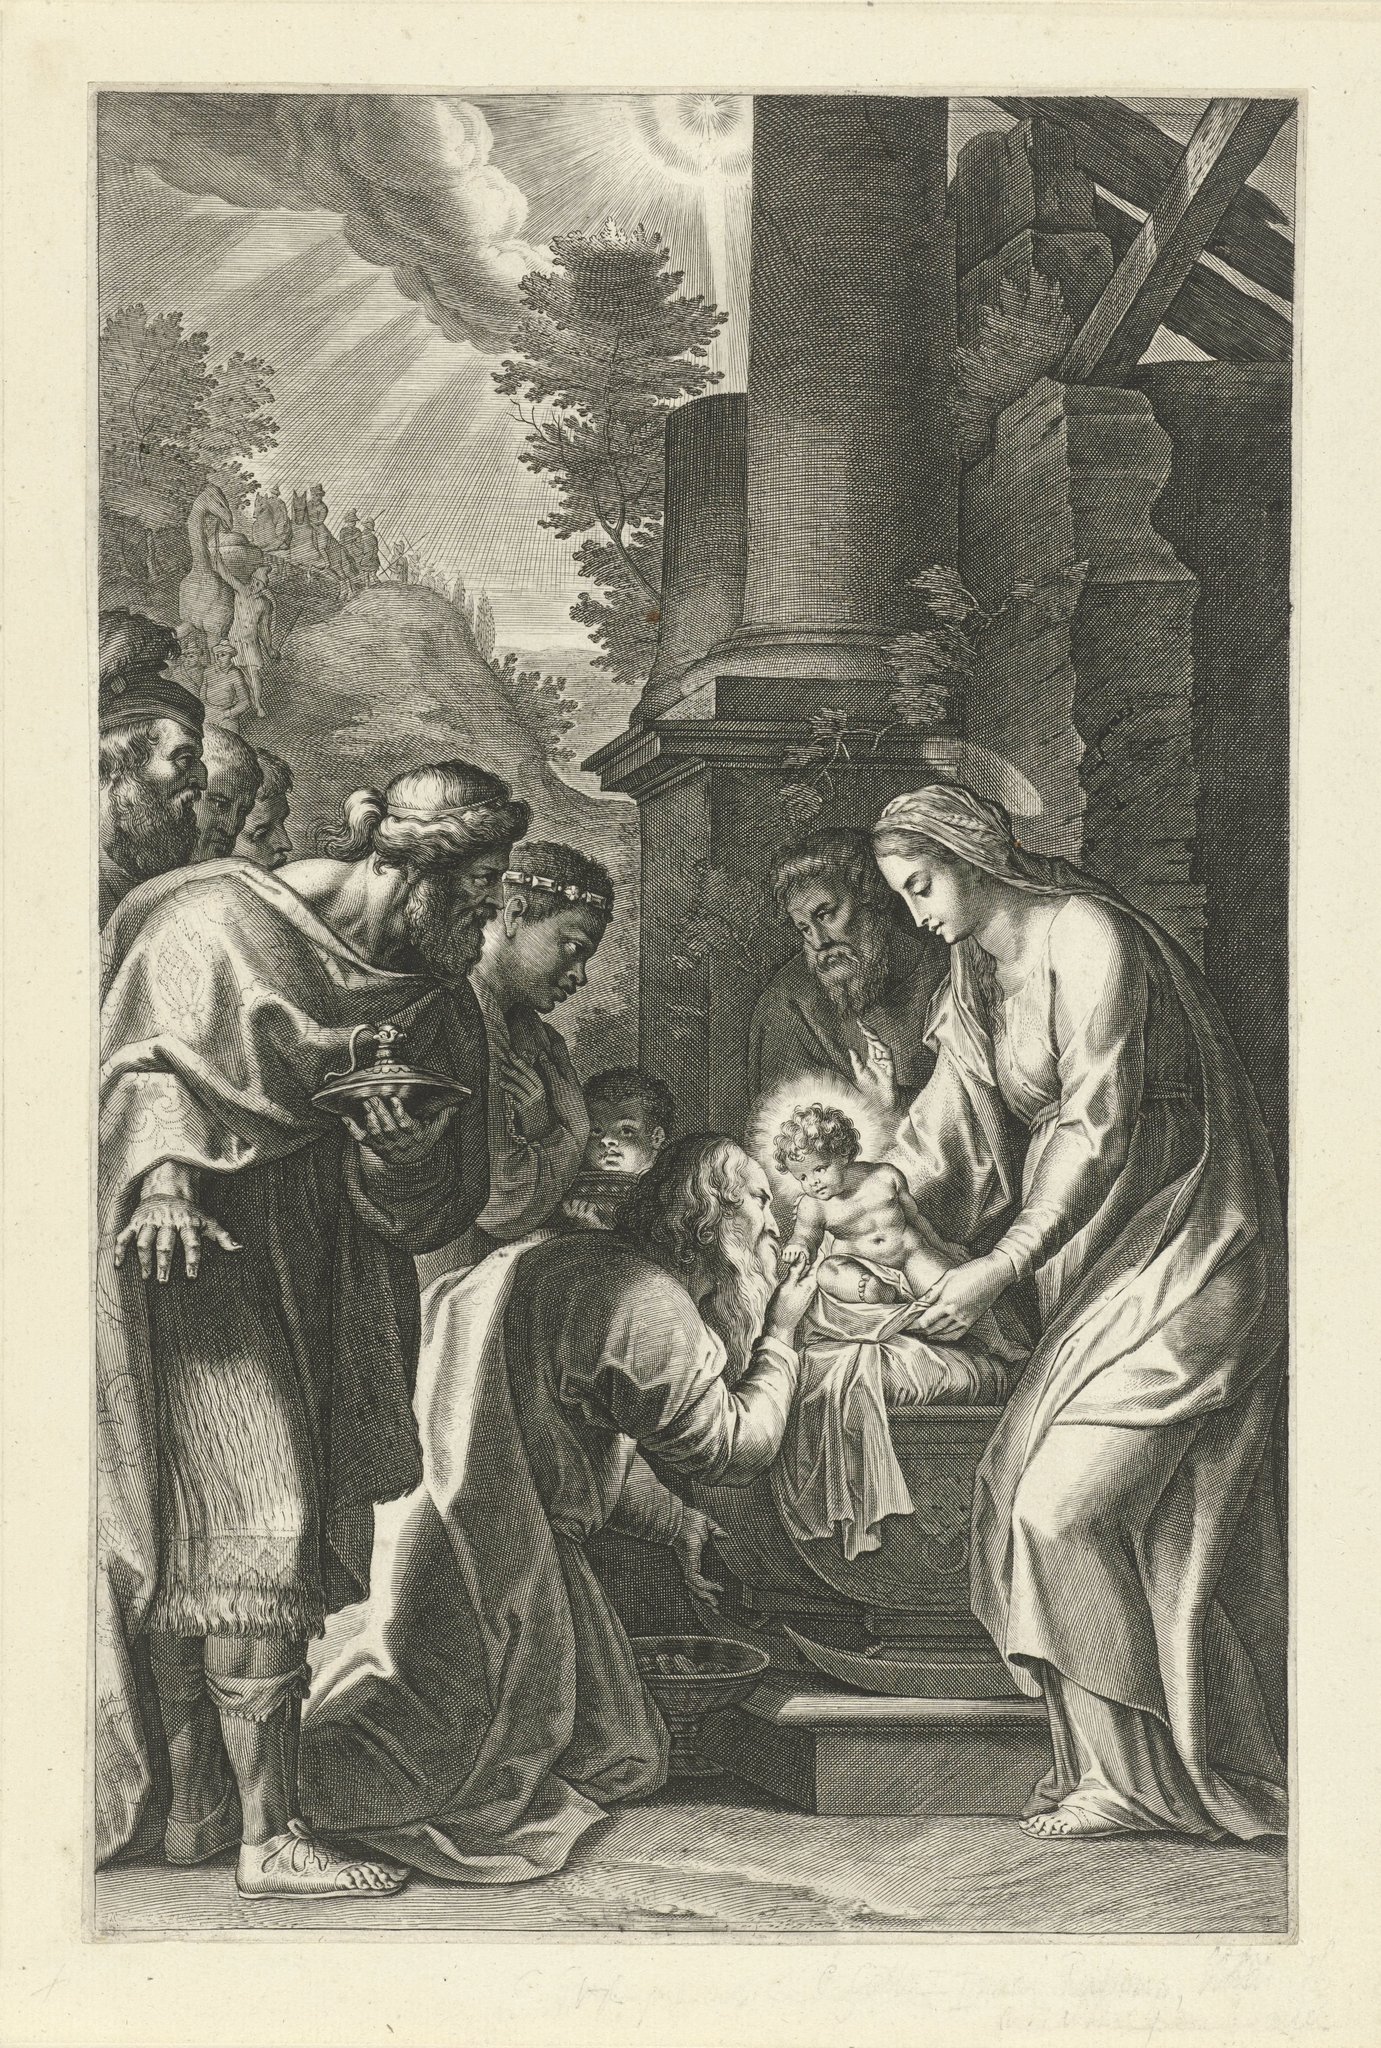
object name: print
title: Aanbidding der koningen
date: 1614-1683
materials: paper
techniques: engraving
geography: antwerp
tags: adoration of the kings: the wise men present their gifts to the christ-child (gold, frankincense and myrrh)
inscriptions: collector's mark: Lugt 240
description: Maria en Jozef tonen het Christuskind aan de drie wijzen. De drie bieden het kind hun geschenken aan. Op de achtergrond leden van hun gevolg. In de verte schijnt de ster die hen naar de stal in Bethlehem heeft geleid.